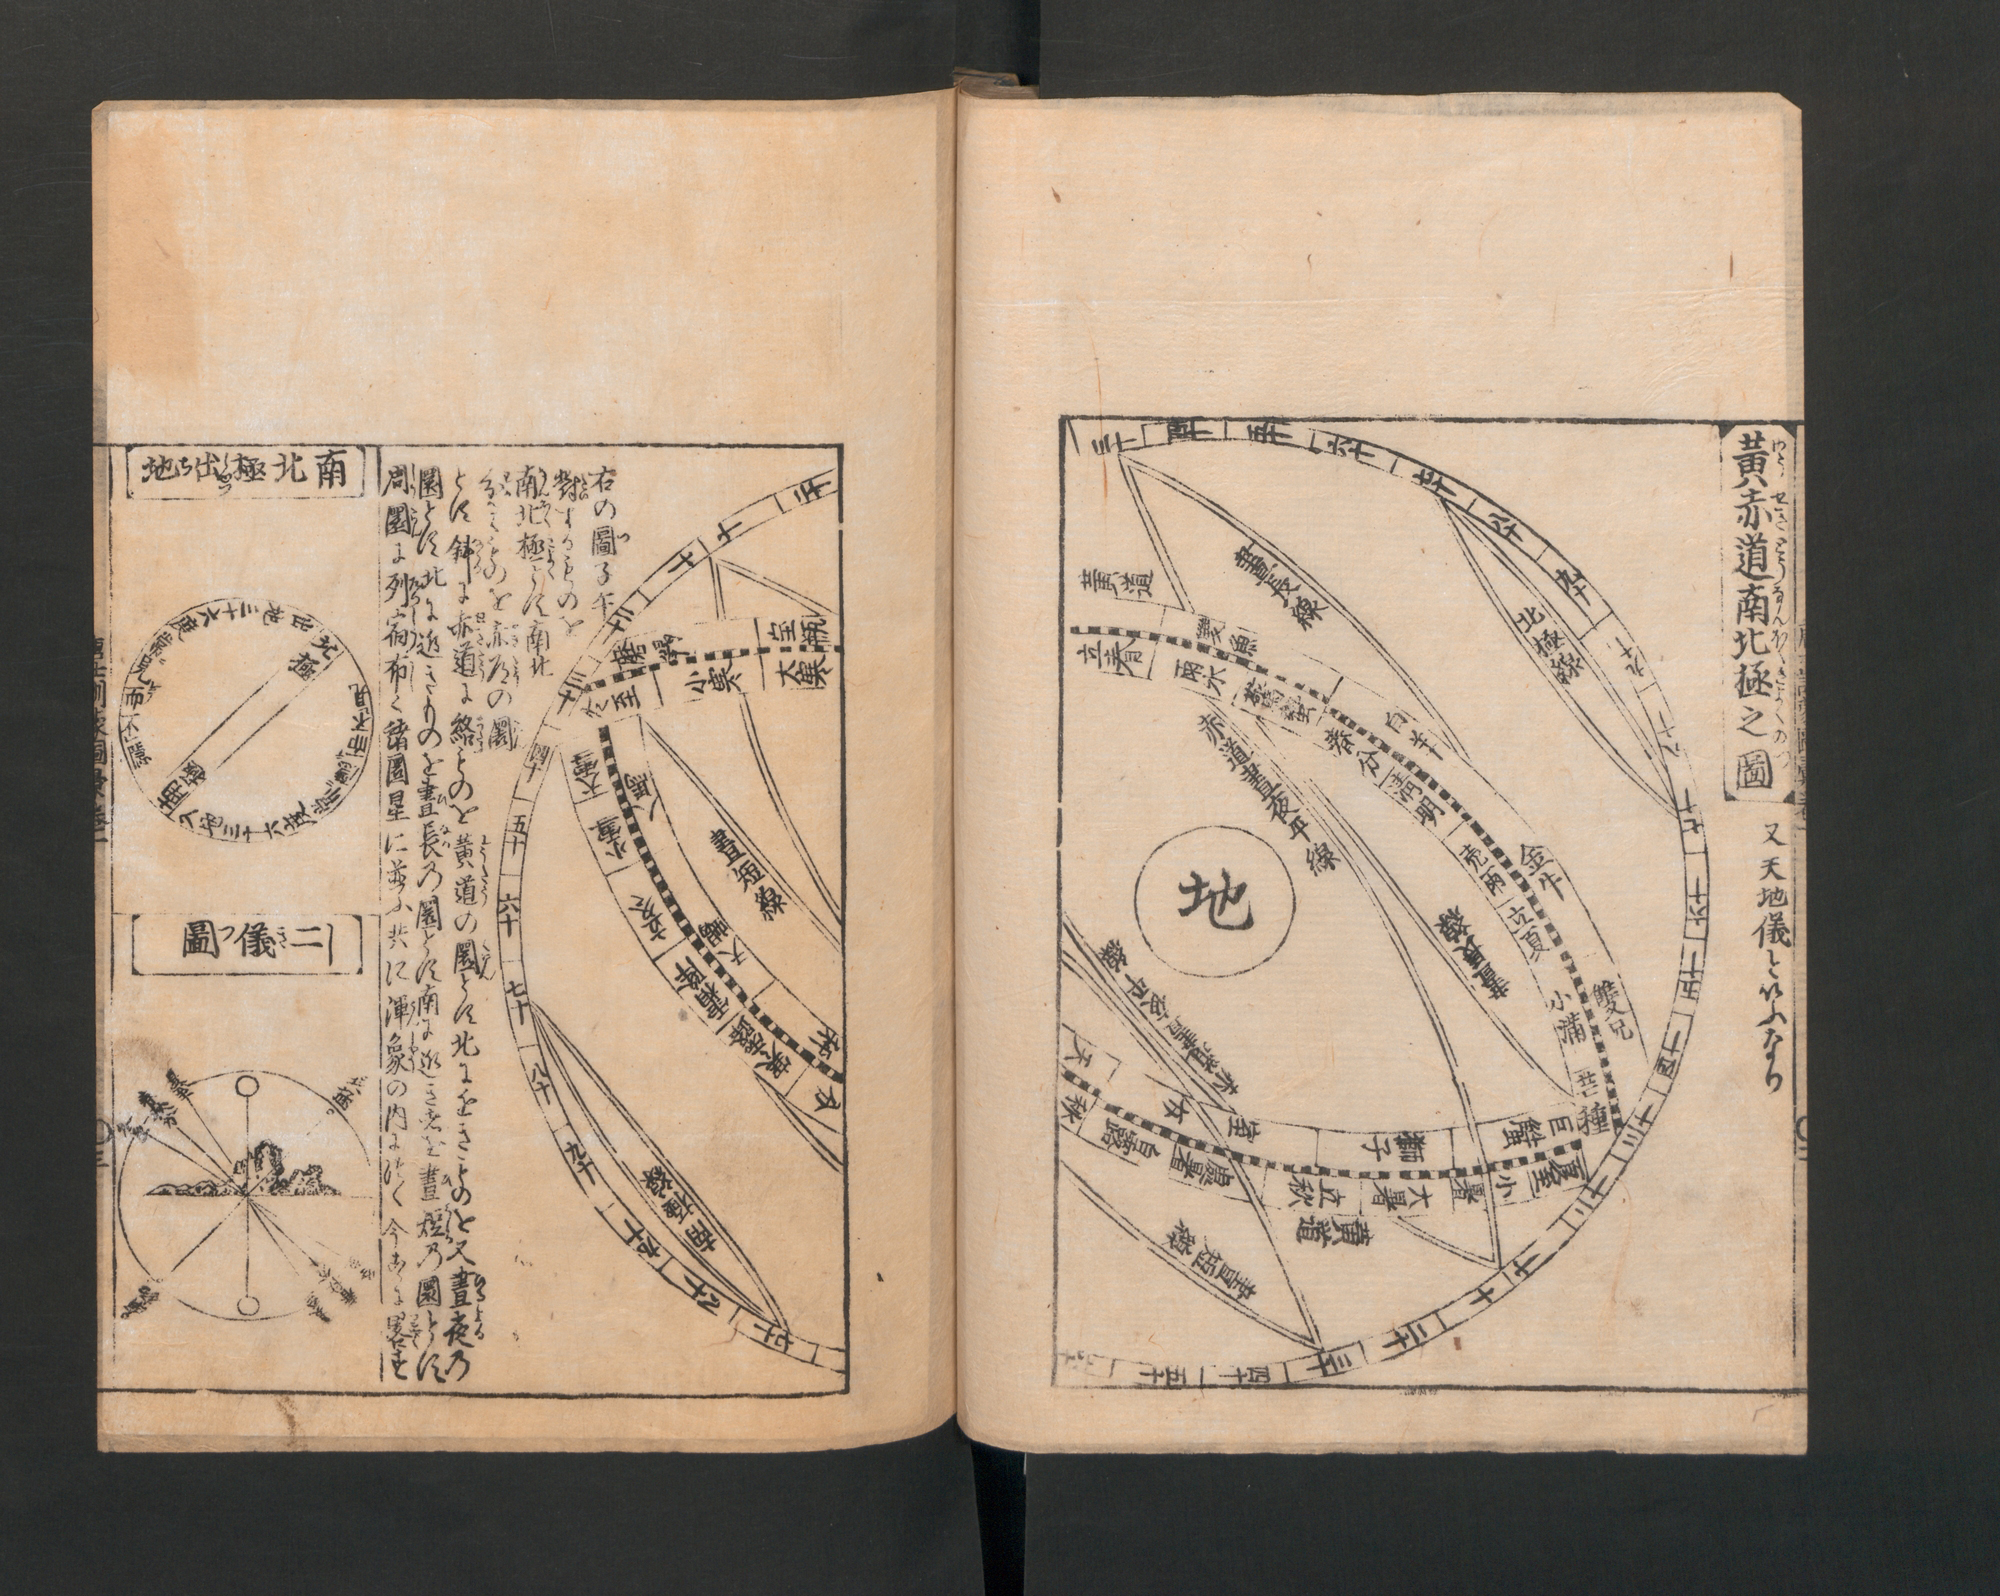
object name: illustrated book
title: Illustrated Encyclopedia of China (Morokoshi kinmō zui) 唐土訓蒙図彙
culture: japanese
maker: tachibana morikuni 橘守国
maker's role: artist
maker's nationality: japanese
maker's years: 1679-1748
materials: ink, paper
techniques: woodblock print